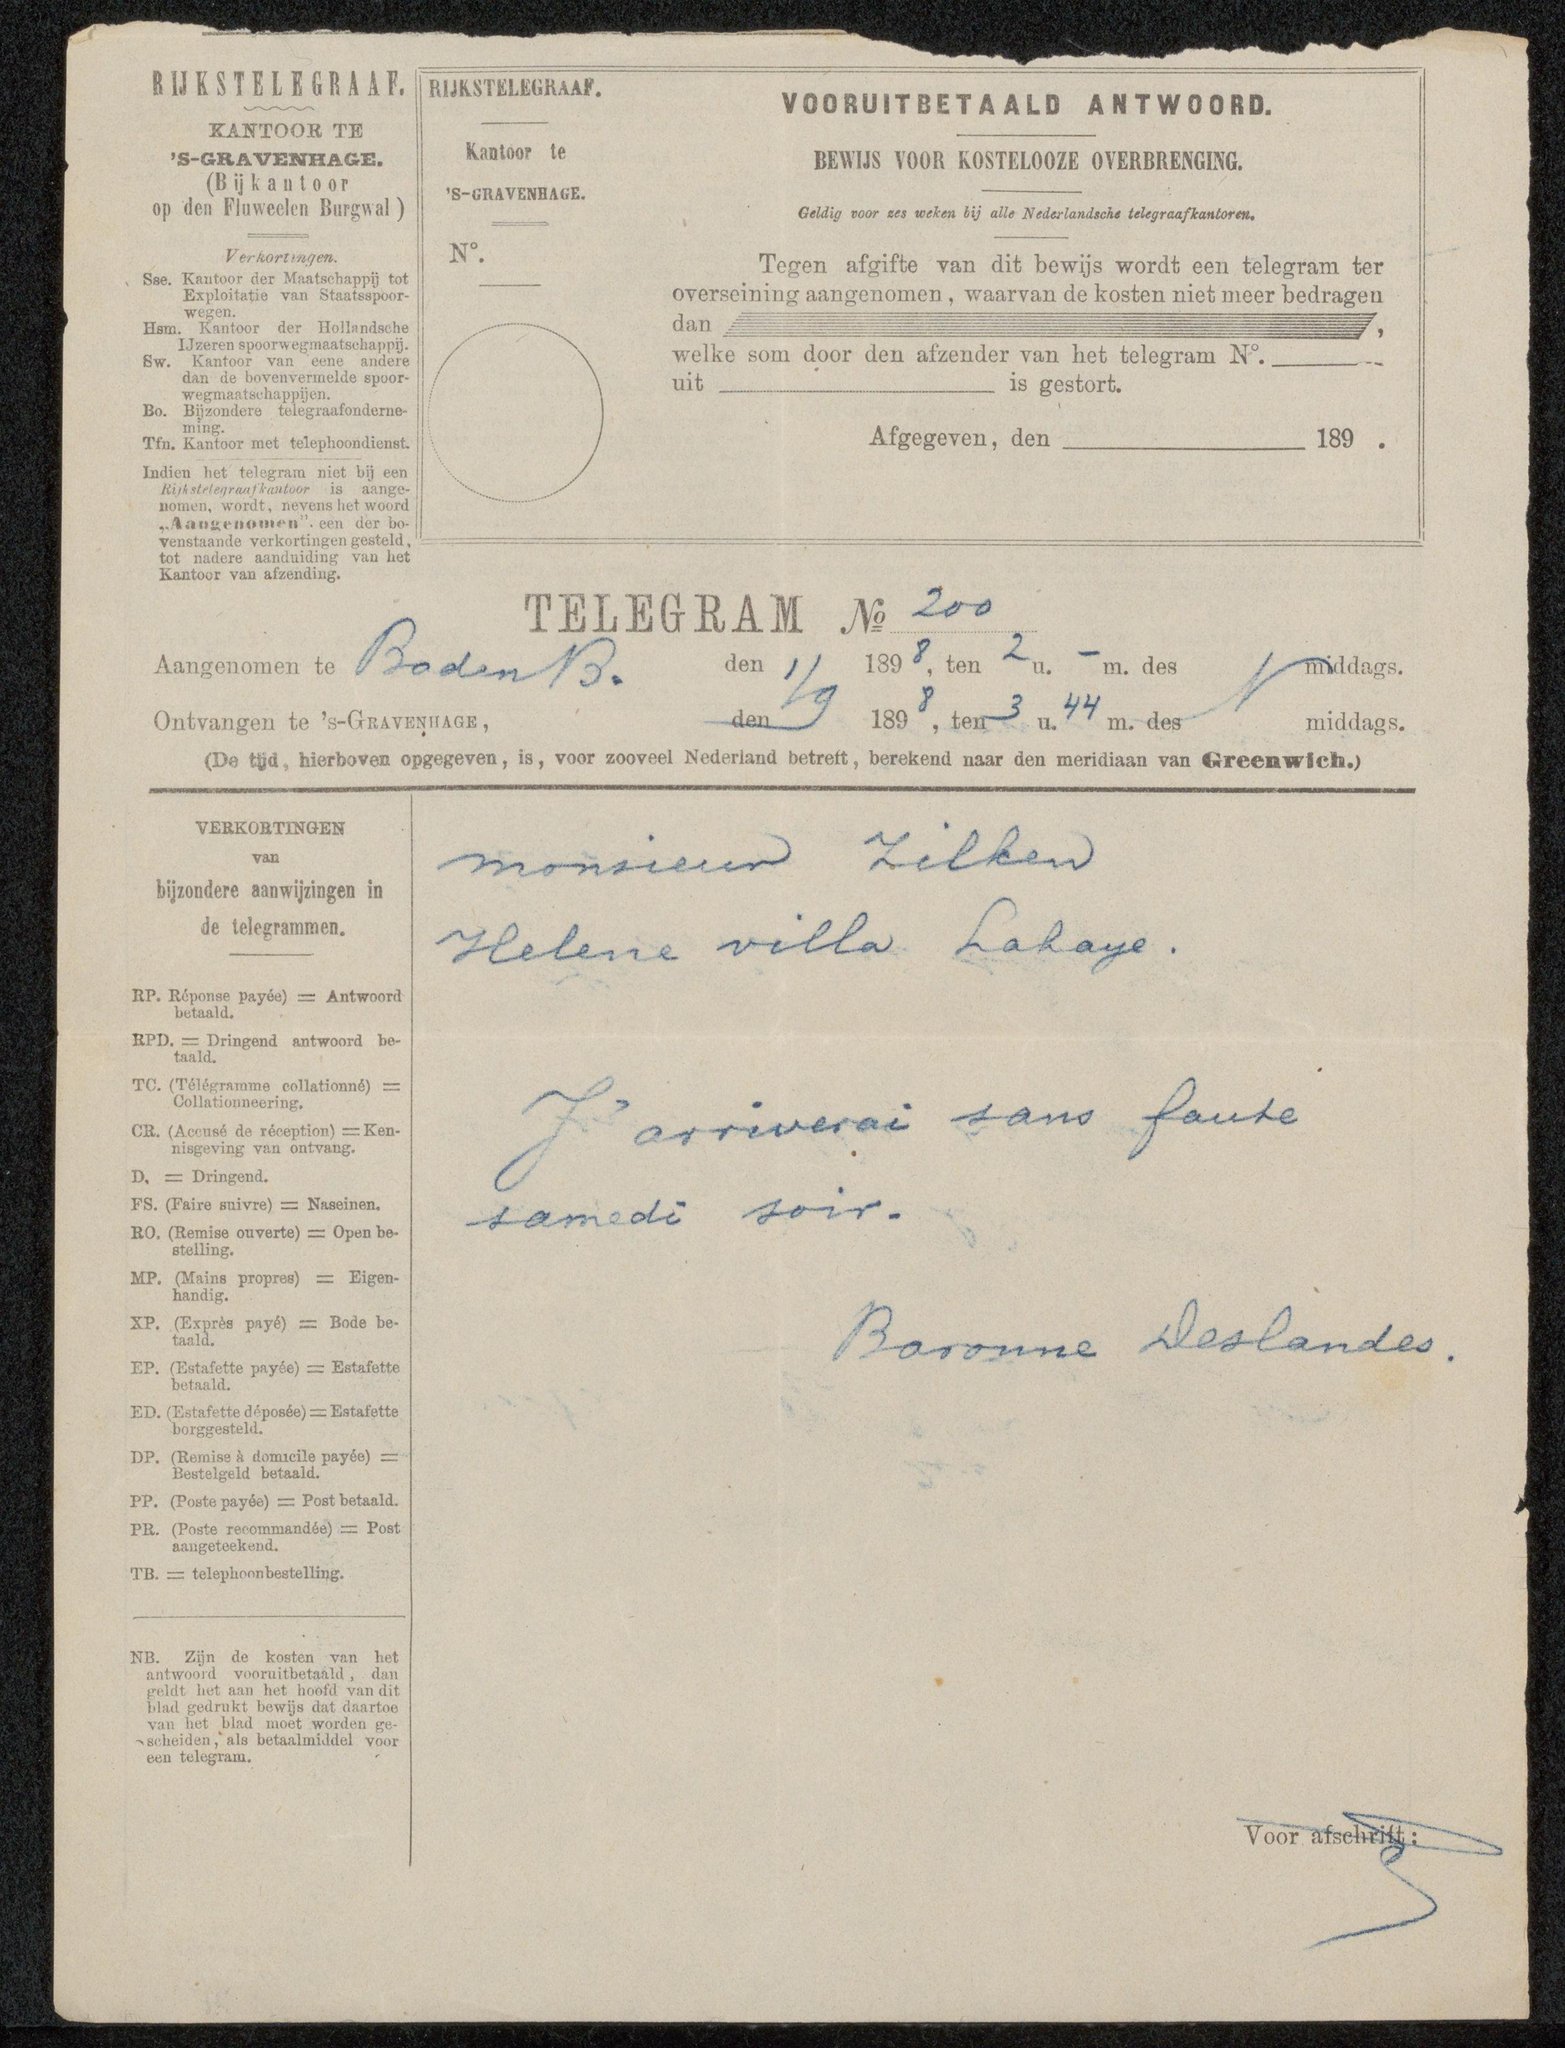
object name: telegram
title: Telegram aan Philip Zilcken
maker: baronne madeleine deslandes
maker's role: schrijver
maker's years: 1866-1929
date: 1898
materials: paper, pencil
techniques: printing, writing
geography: baden-baden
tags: the hague, painter, philip zilcken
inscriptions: collector's mark: ‘RPK’